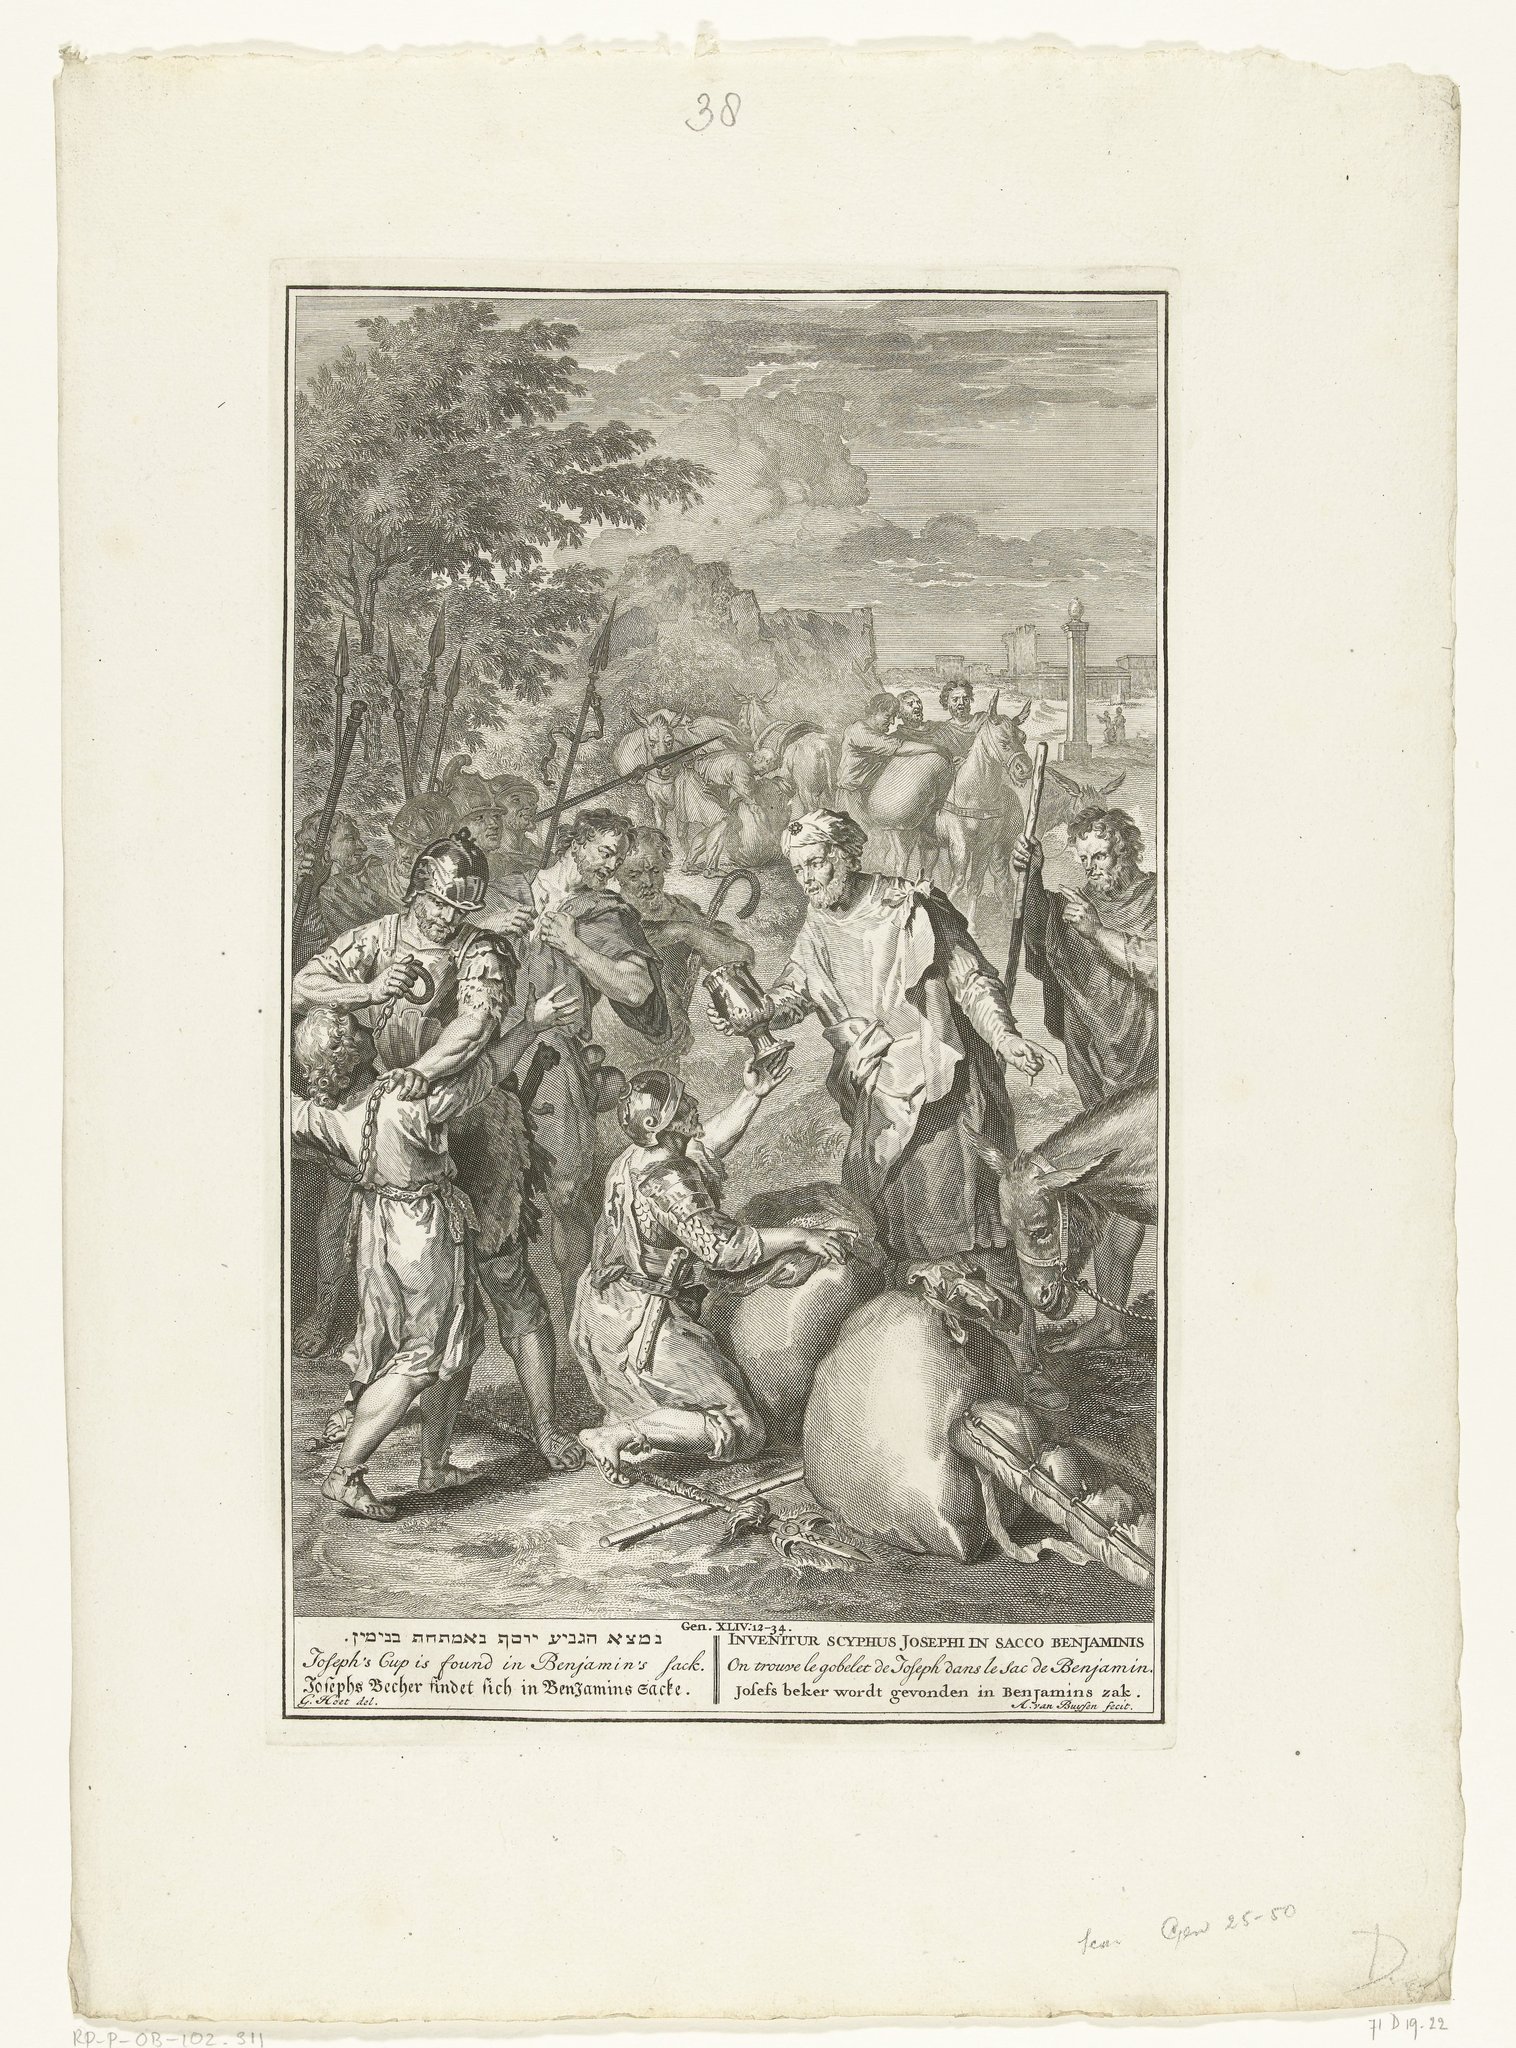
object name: print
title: Jozefs beker wordt gevonden in Benjamins zak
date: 1711-1720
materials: paper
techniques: engraving, etching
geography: amsterdam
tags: the cup is found in benjamin's sack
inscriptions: collector's mark: Lugt 2228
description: In opdracht van Jozef doorzoeken zijn mannen de bagage van zijn broers. In de zak van zijn jongste broer Benjamin vinden zij een gouden beker. Benjamin wordt gevangen genomen en terug gebracht naar Jozef. Illustratie voor het Oude Testament, Gen. 44: 12-34. Onder de voorstelling een titel in het Hebreeuws, Engels, Duits, Latijn, Frans en Nederlands.